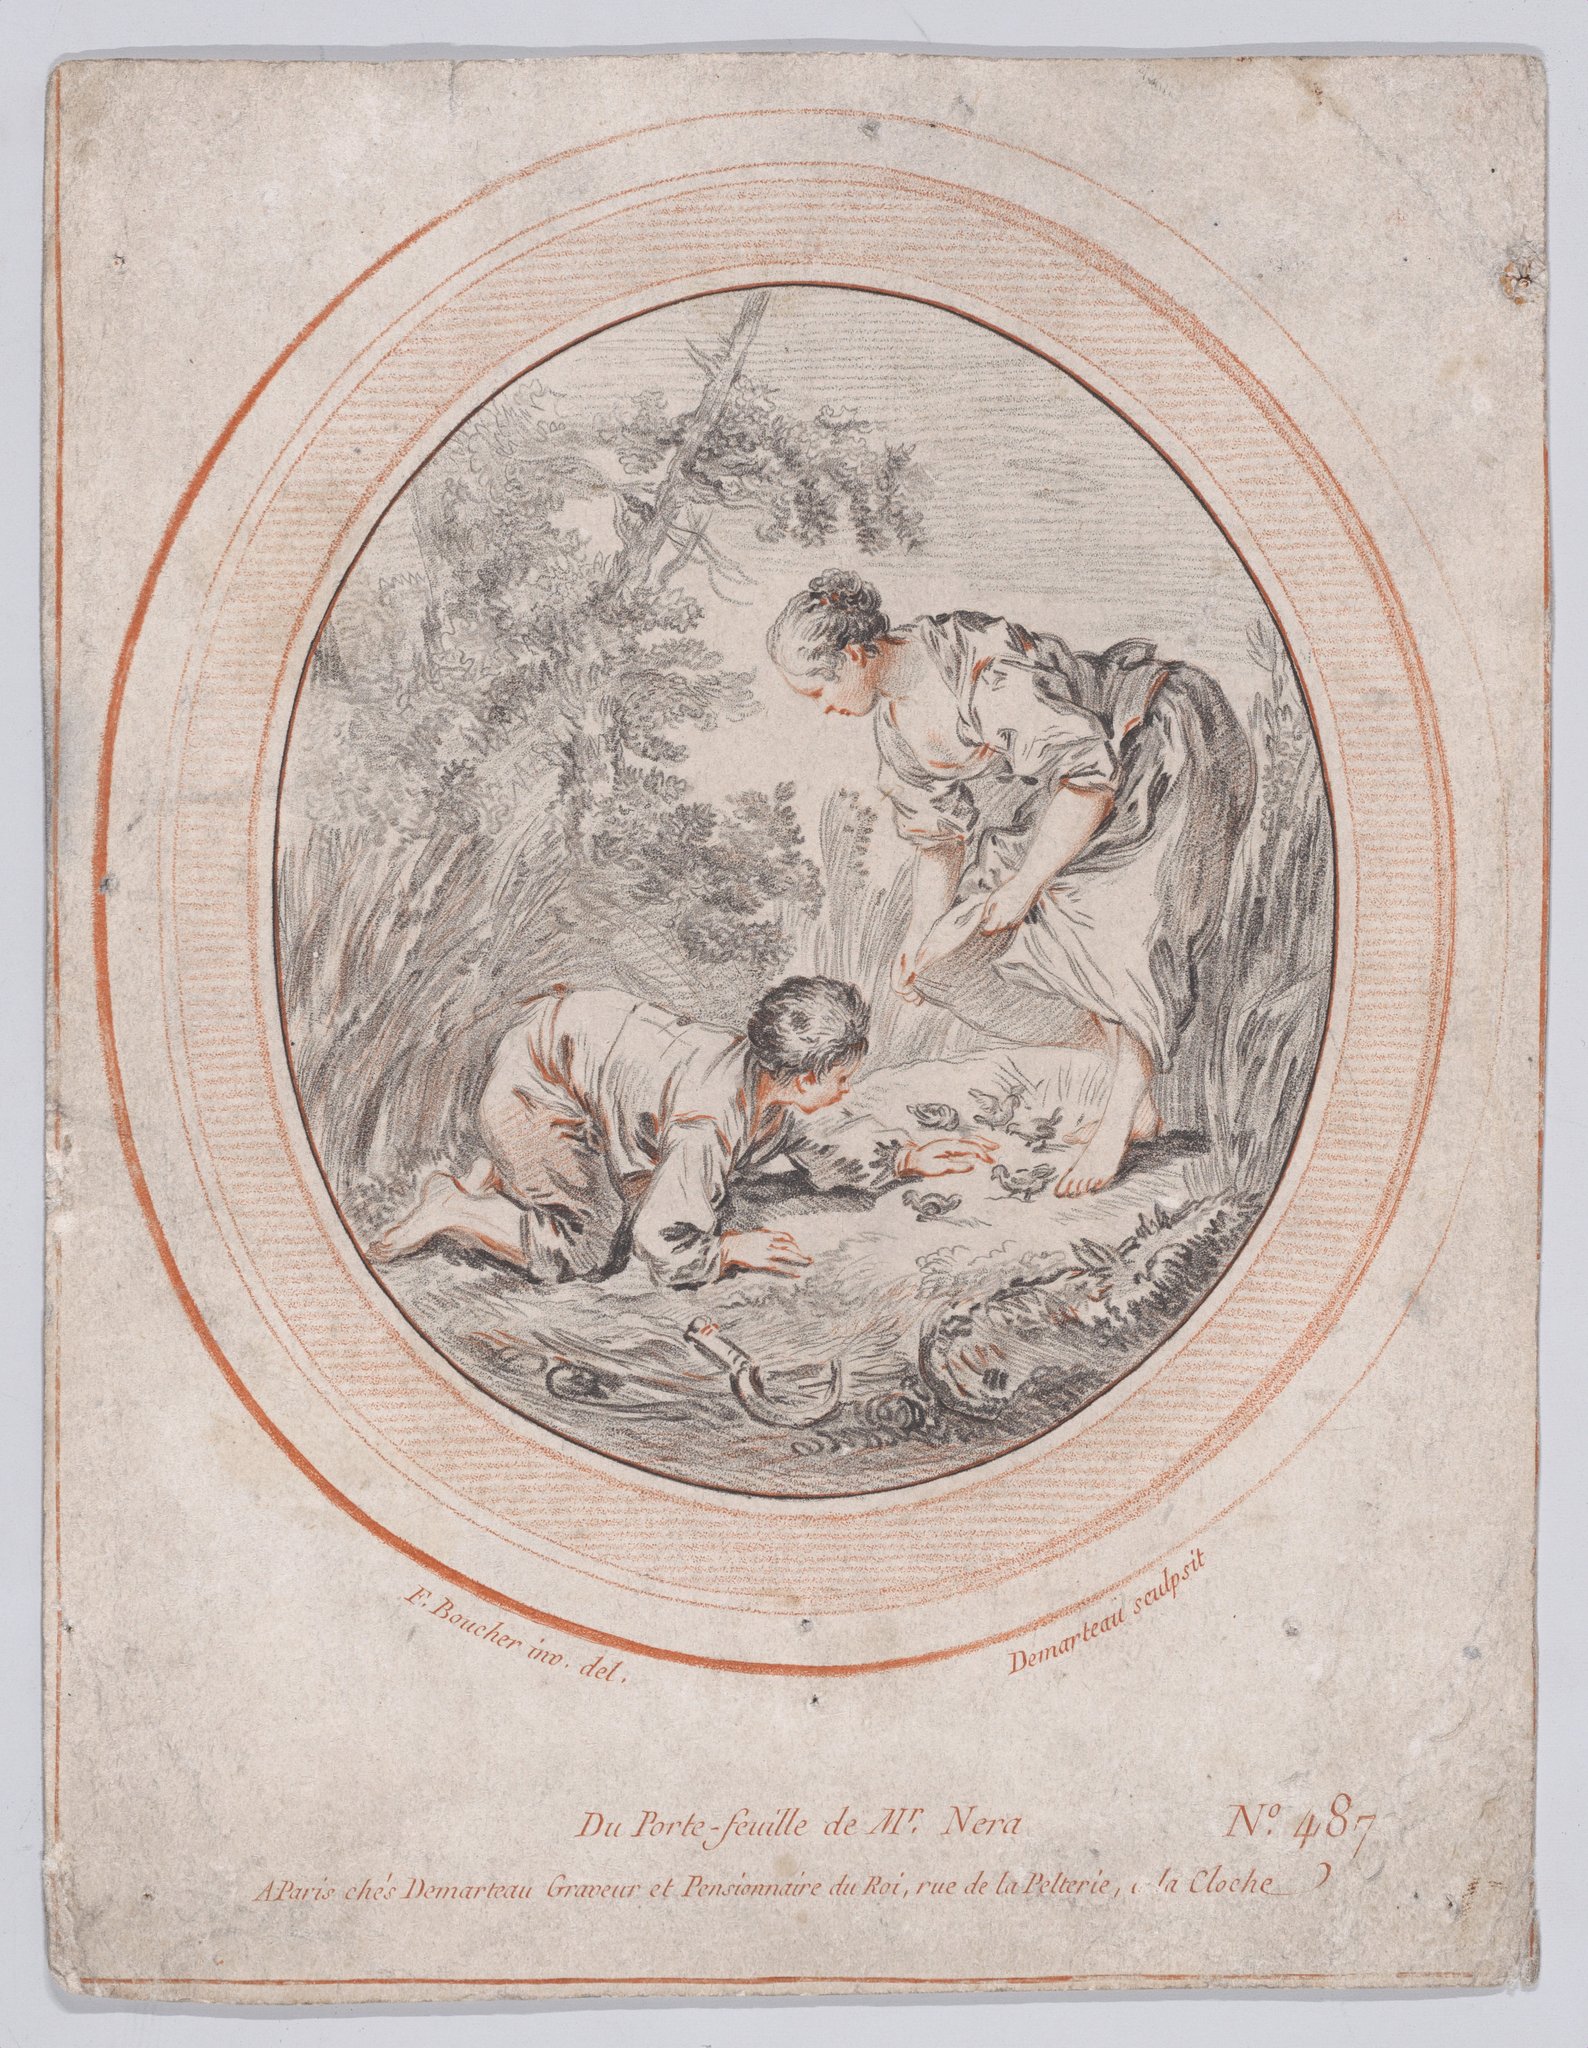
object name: print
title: Pastorale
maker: gilles demarteau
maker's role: artist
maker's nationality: french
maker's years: 1722-1776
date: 1701-1800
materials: ink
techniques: printmaking, etching, printing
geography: france